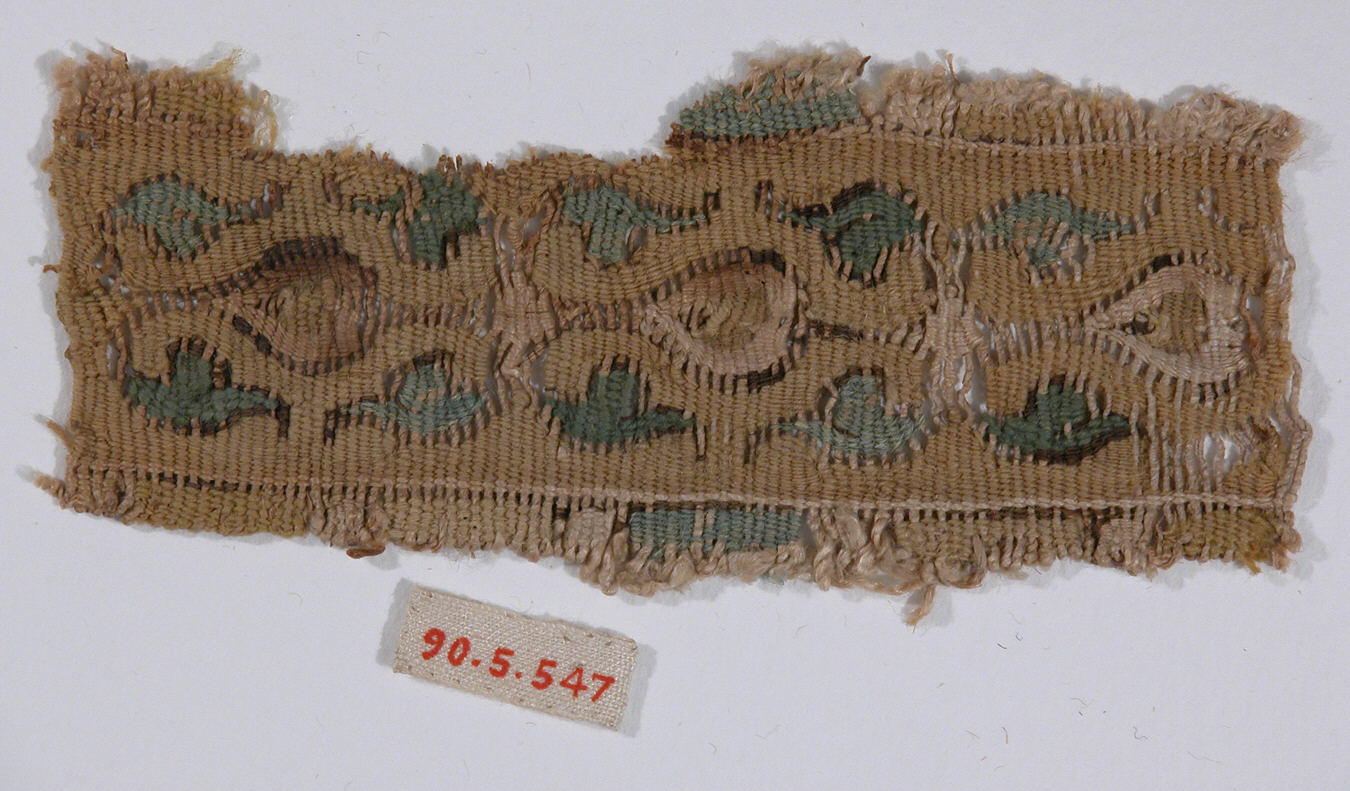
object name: textile fragment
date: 401-500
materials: linen, wool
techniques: weave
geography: egypt